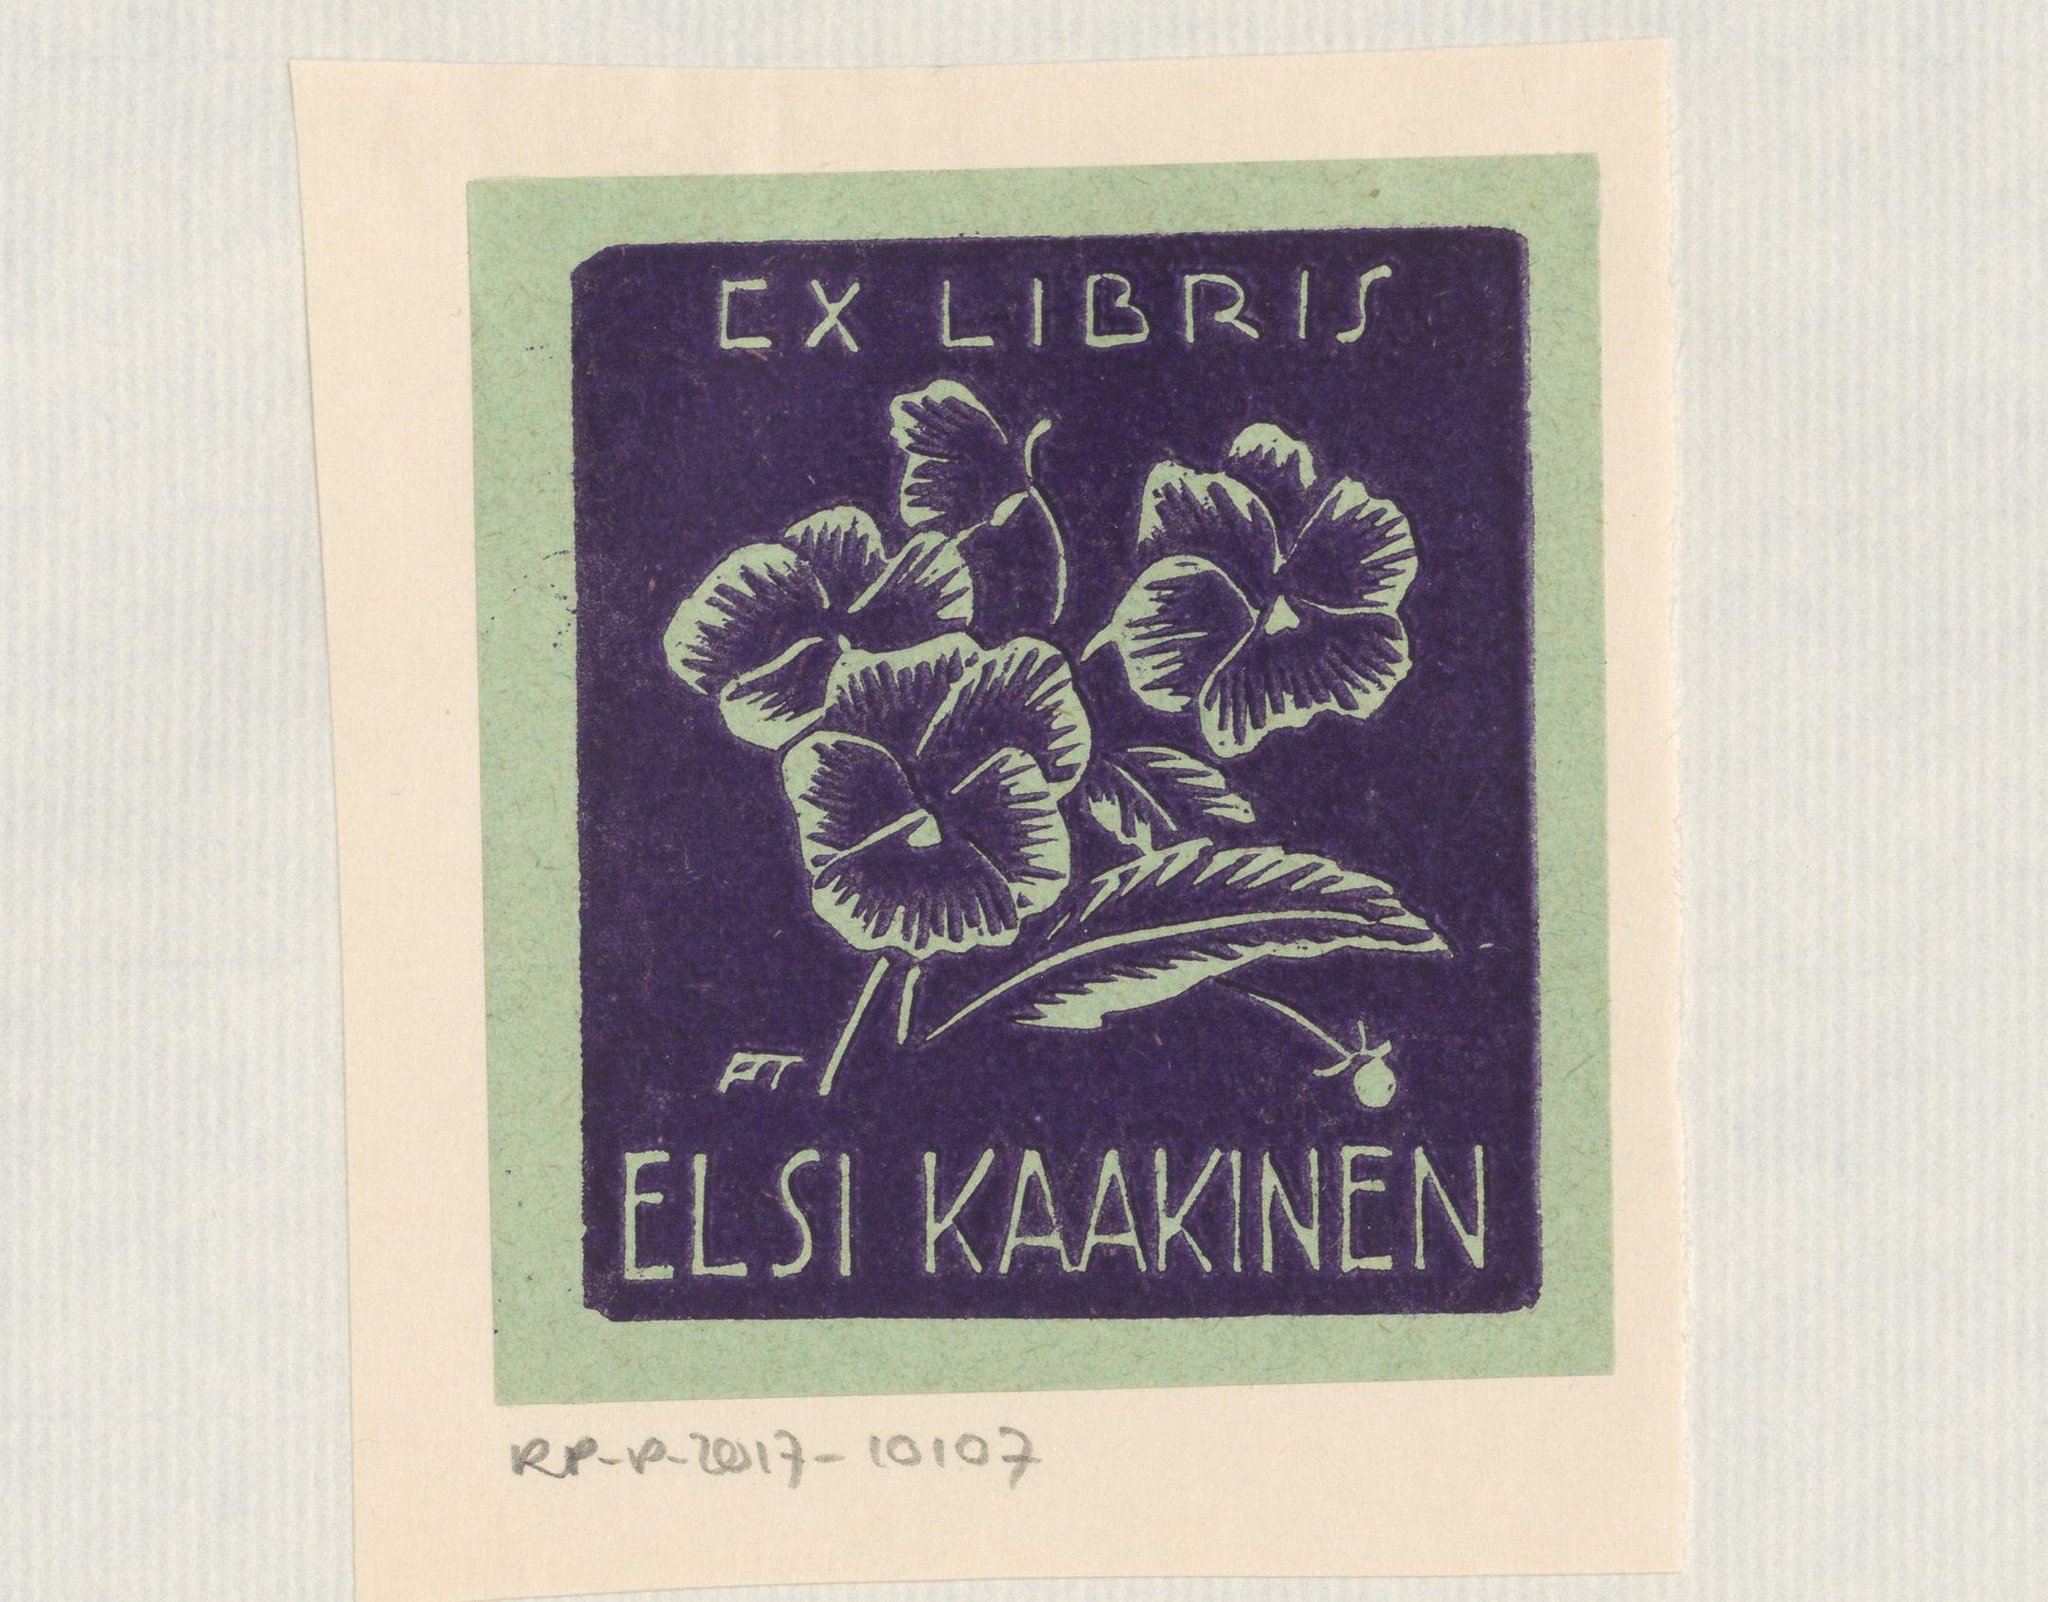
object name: bookplate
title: Ex libris van Elsi Kaakinen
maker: pekka törmä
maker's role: print maker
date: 1945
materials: paper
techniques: linocut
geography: denmark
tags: flowers: violet